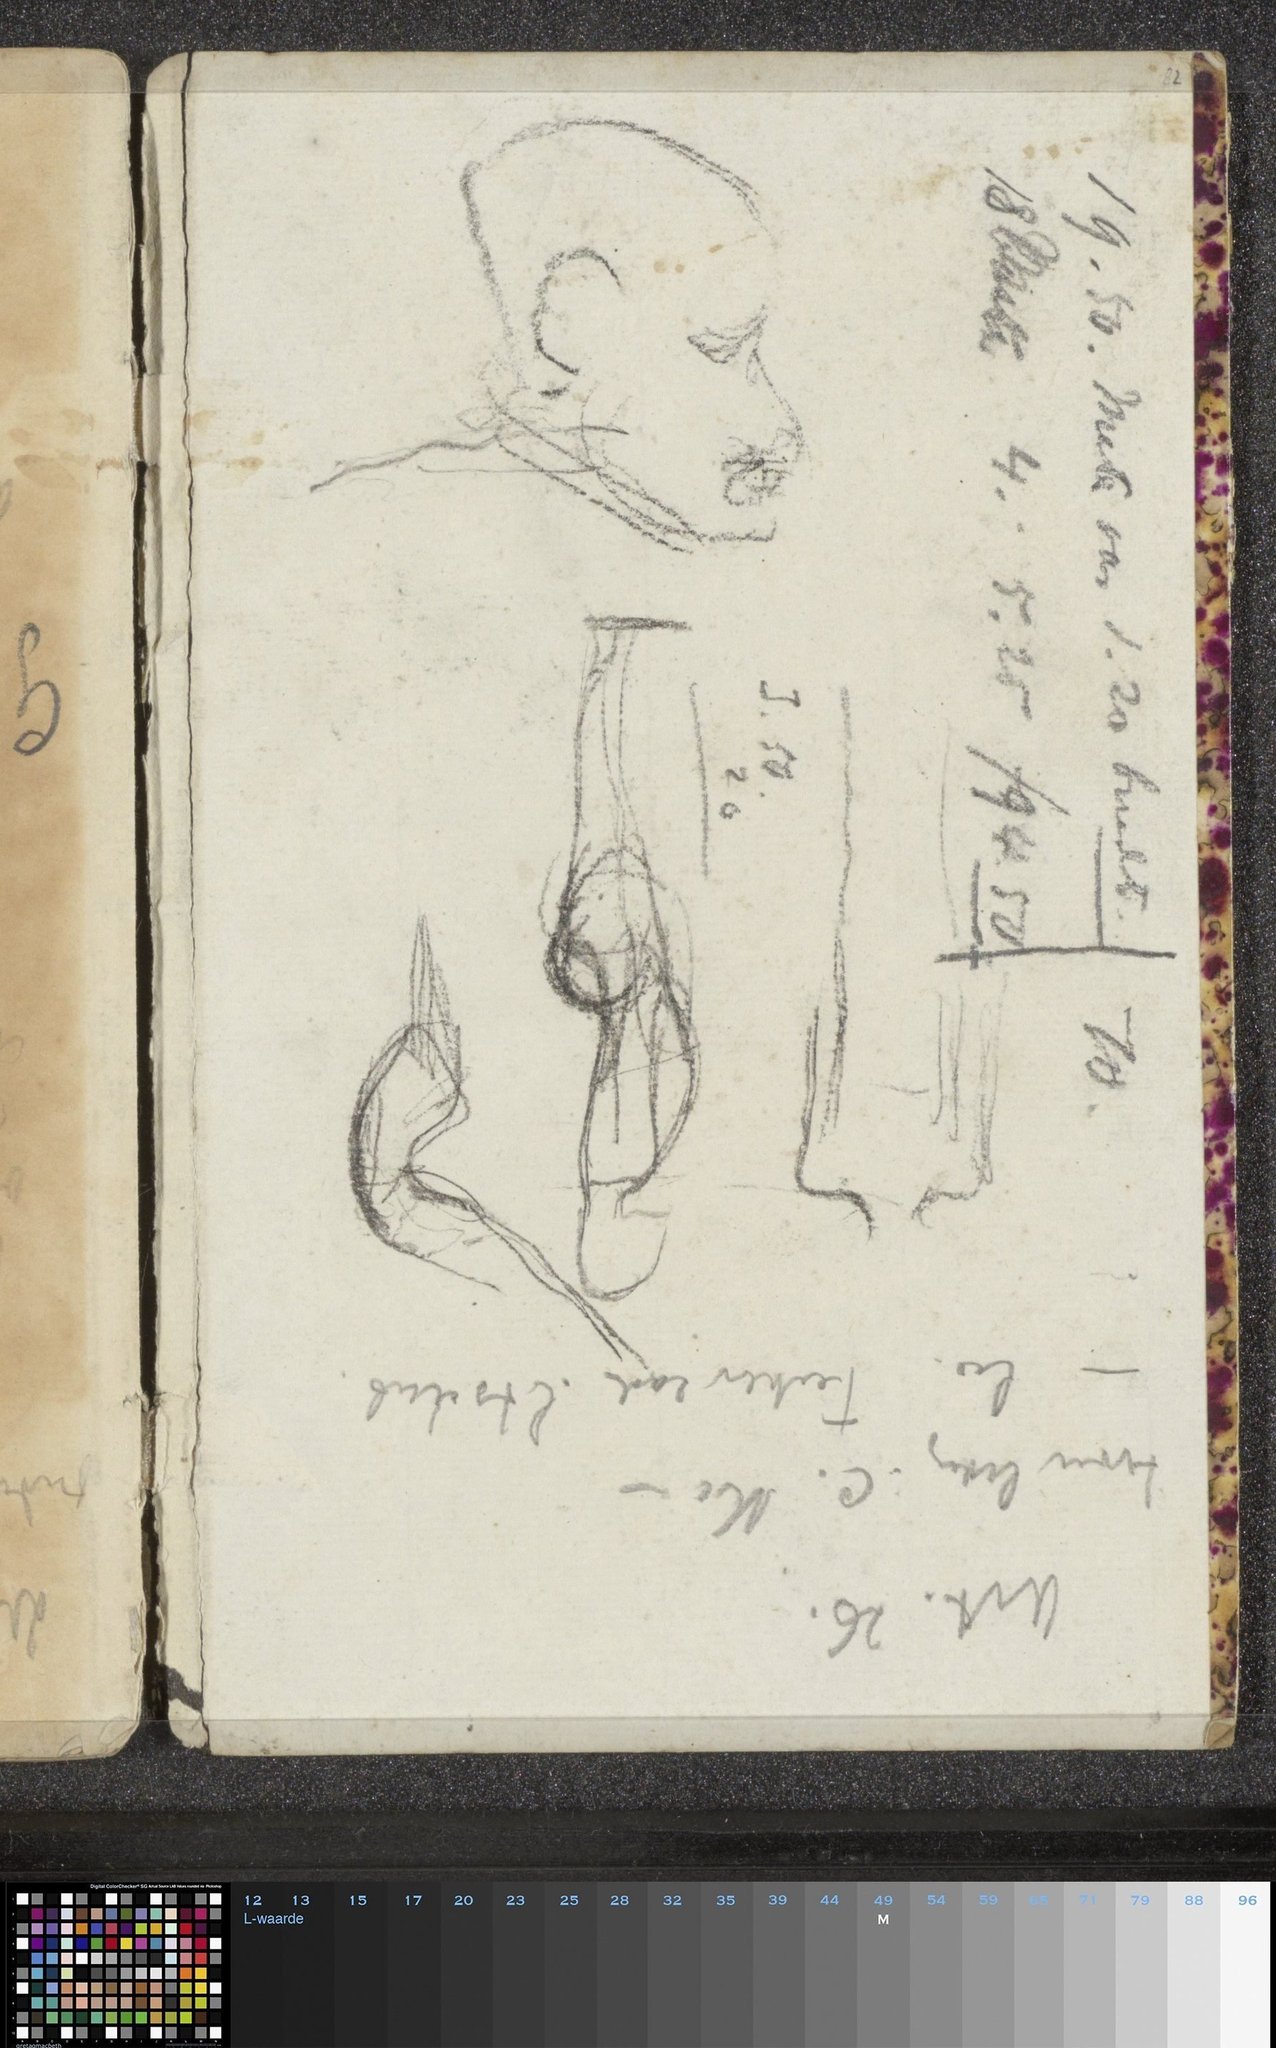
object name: endleaf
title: Figuurstudies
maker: george hendrik breitner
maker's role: draughtsman, painter, print maker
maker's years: 1857-1923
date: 1886-1903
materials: chalk, paper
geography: amsterdam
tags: head (human), anatomy (non-medical)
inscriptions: annotation: ‘Art. 26./ twee leden[?] [...]/ [...] Teekenzaal Etsstuk/ [...]’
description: Pagina 32, achterste schutblad, uit een schetsboek met 15 bladen.